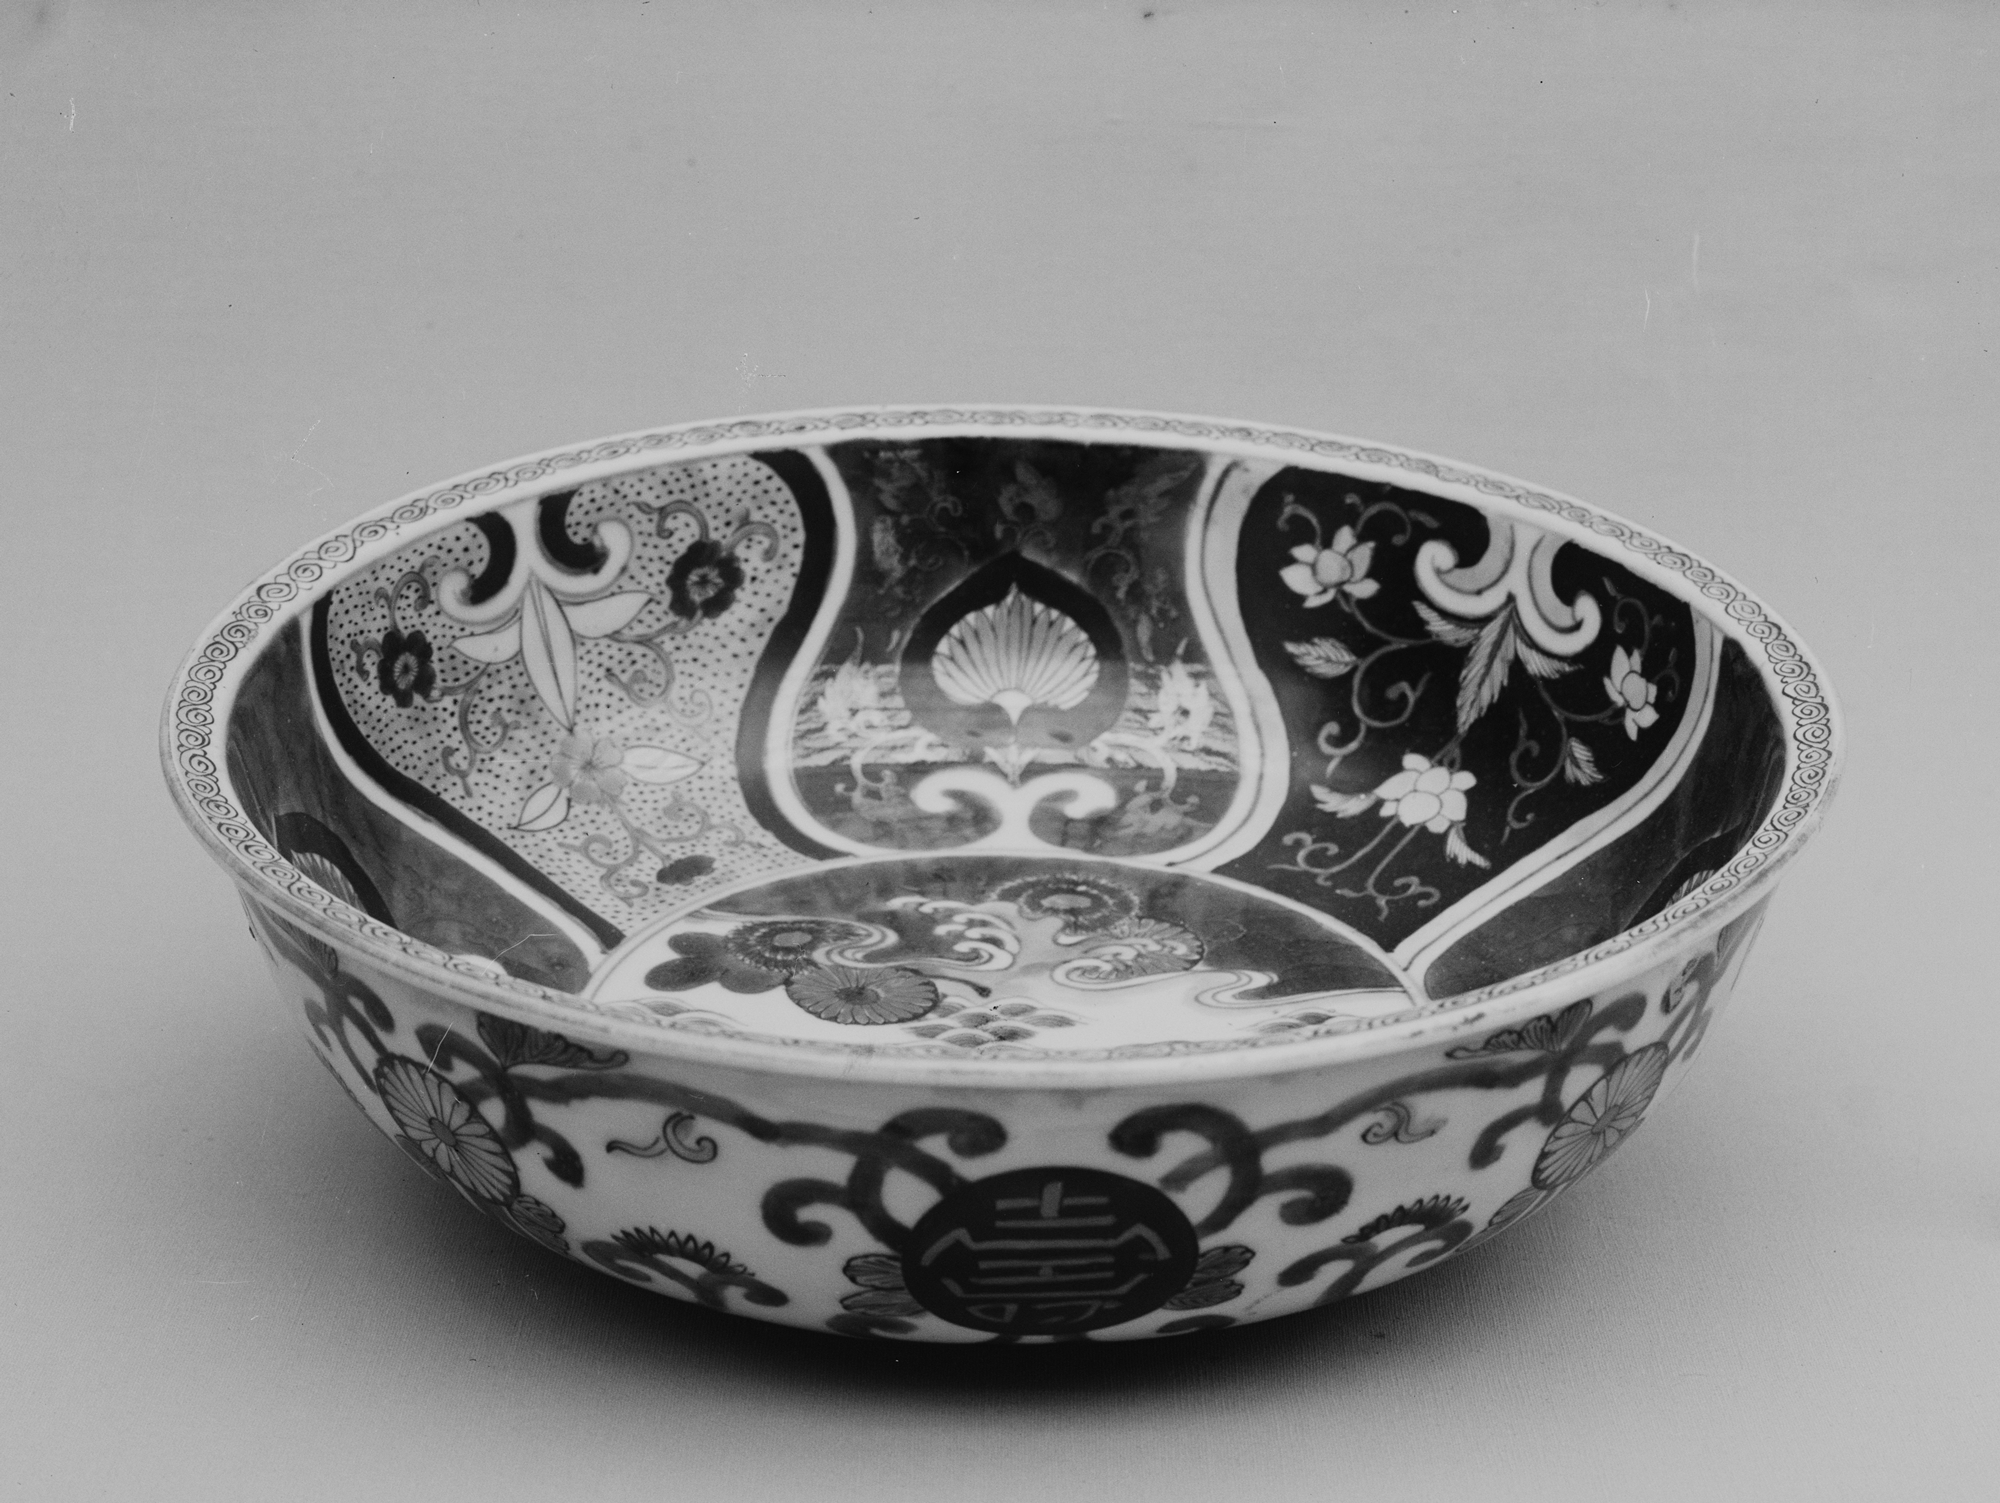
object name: bowl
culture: japanese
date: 1750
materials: enamel, glaze, porcelain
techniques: polychrome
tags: flowers